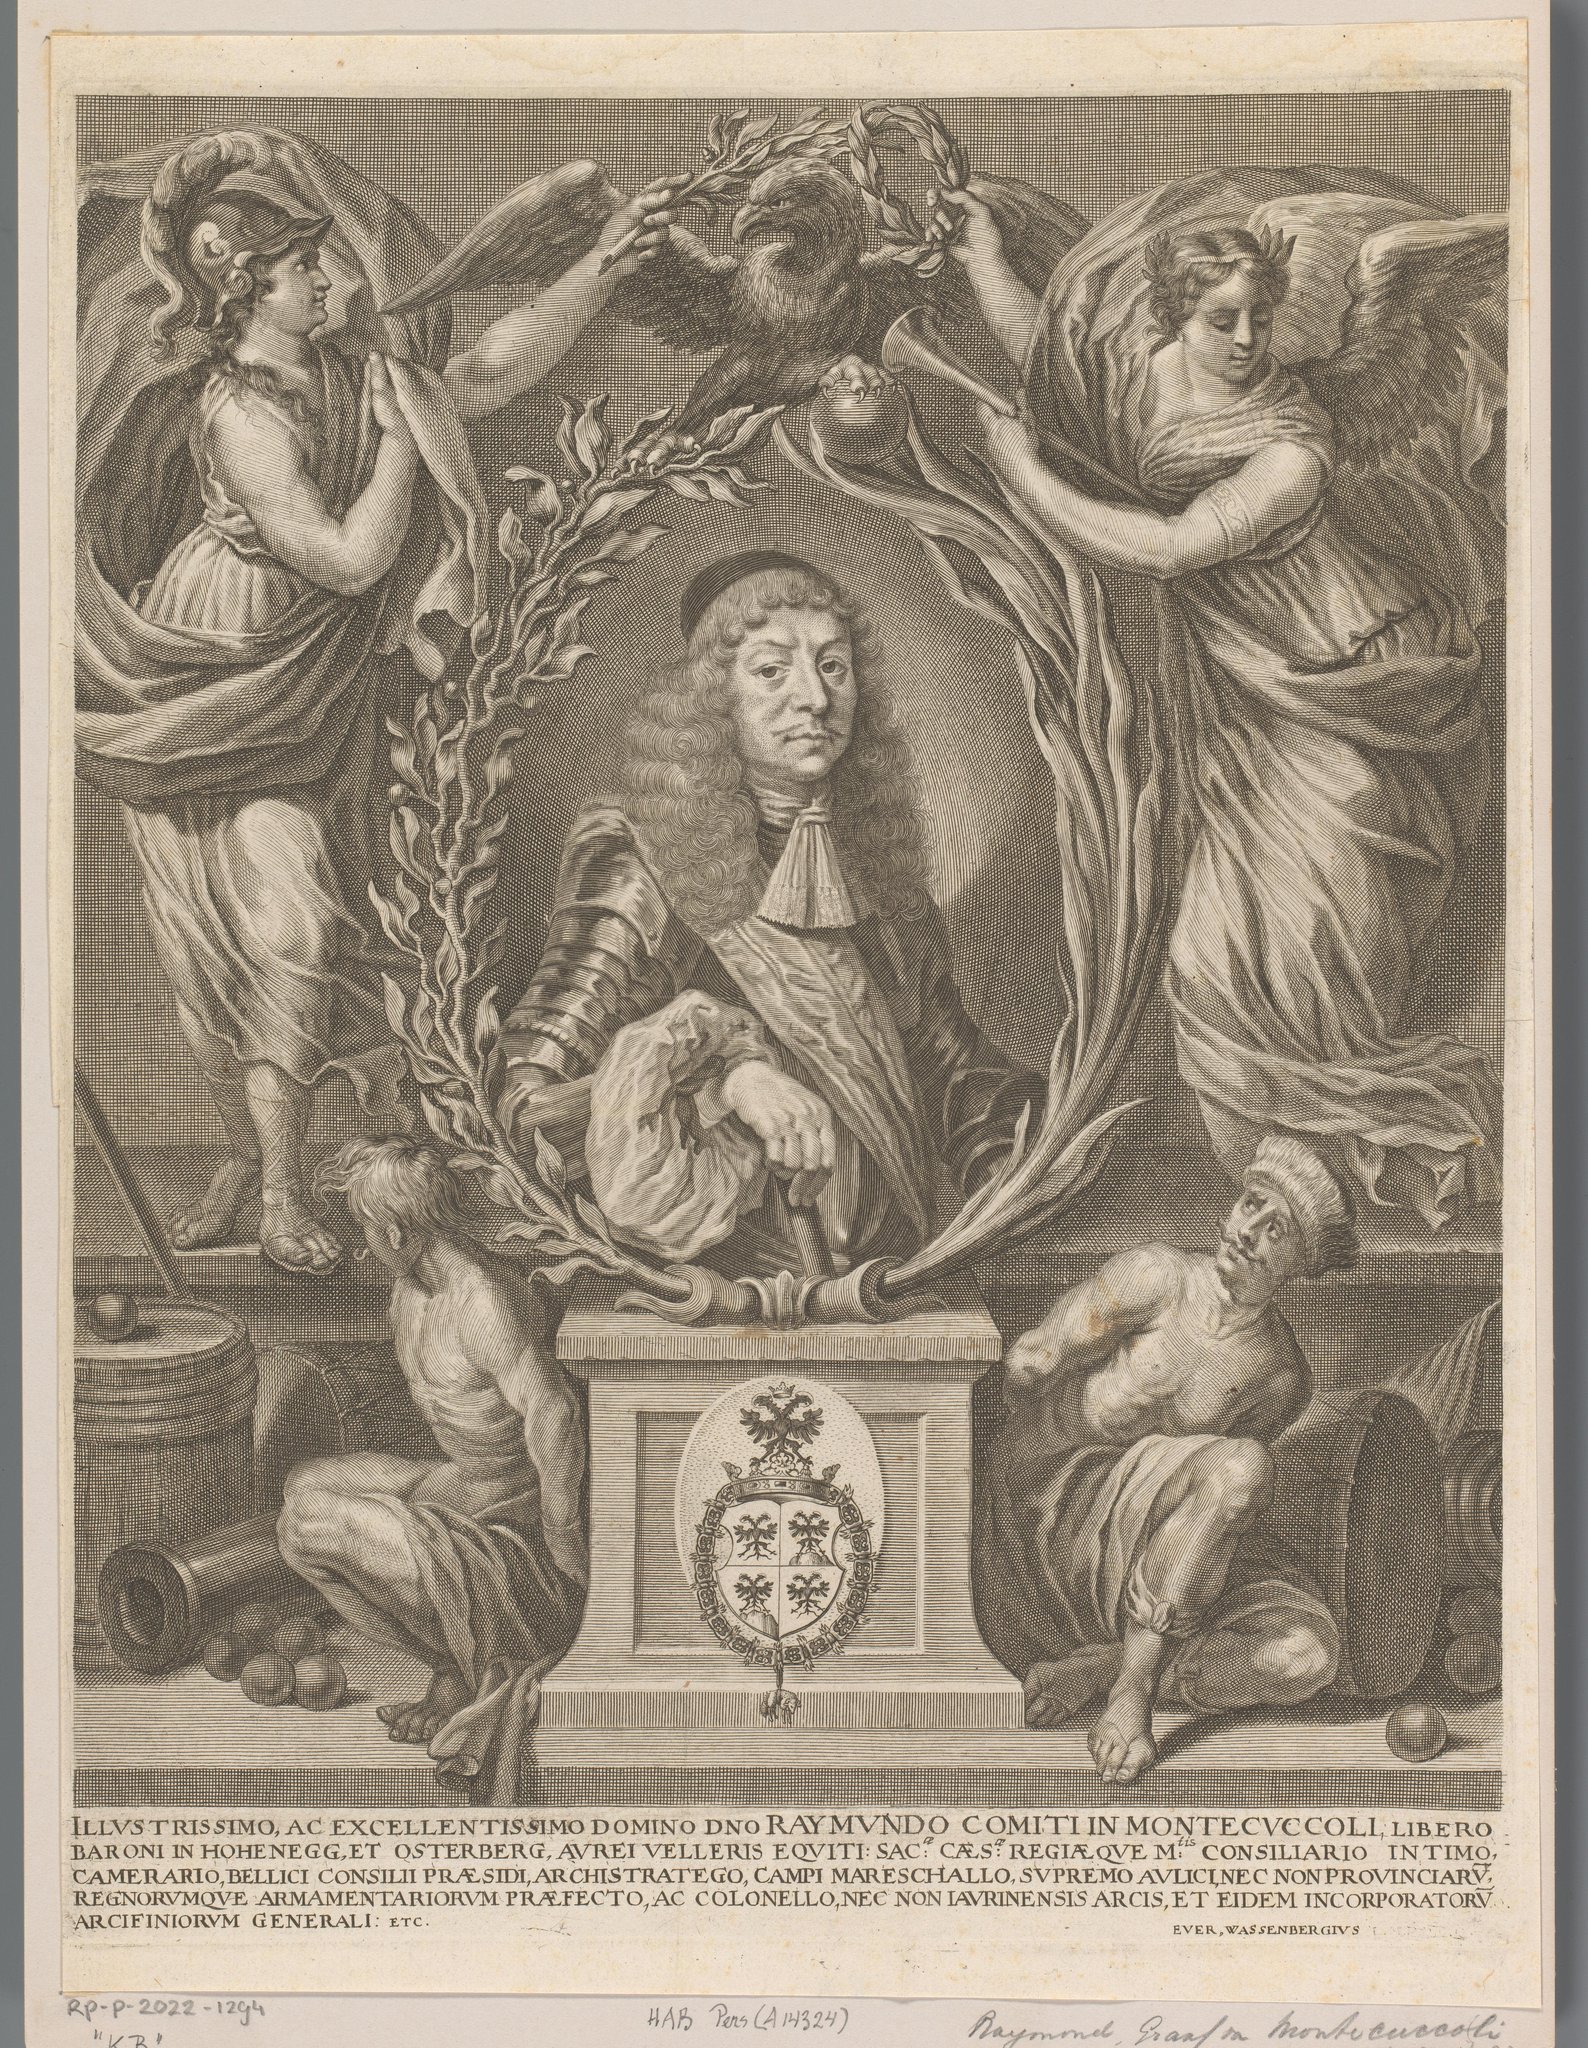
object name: print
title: Portret van Raimondo Montecuccoli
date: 1760-1826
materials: paper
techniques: engraving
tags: historical persons, knighthood order of the golden fleece - insignia of a knighthood order, e.g.: badge, chain (with name of order)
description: Met vijfregelig onderschrift in het Latijn.